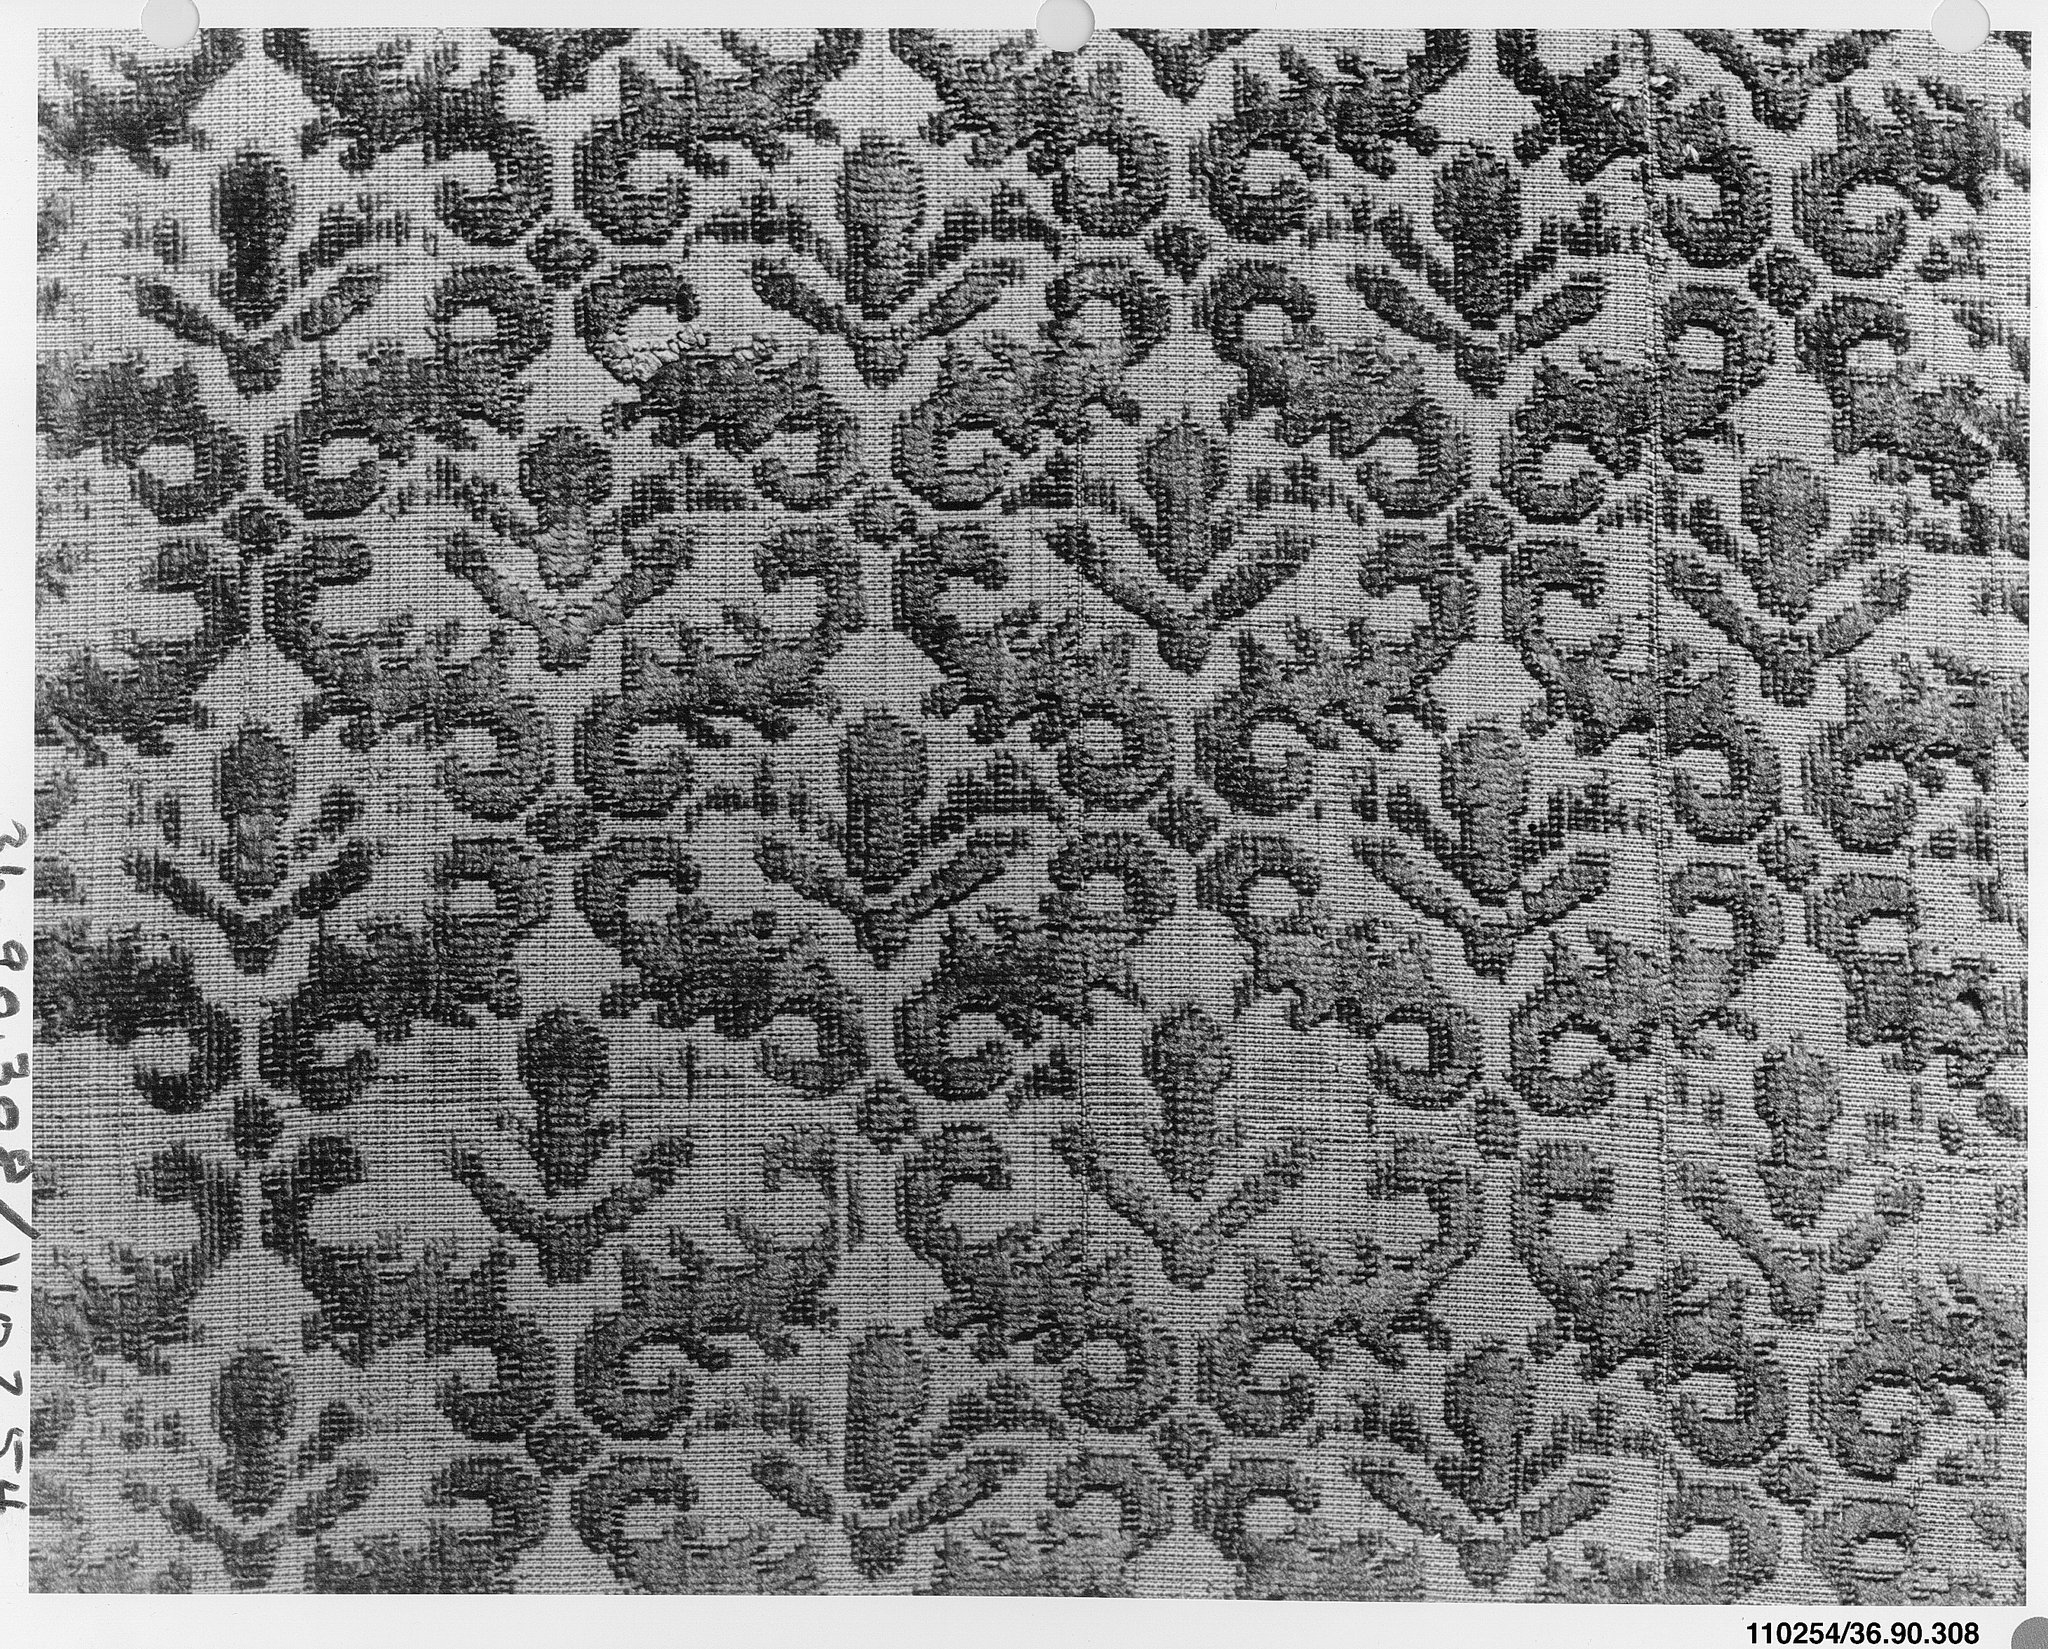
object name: piece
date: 1501-1700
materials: silk